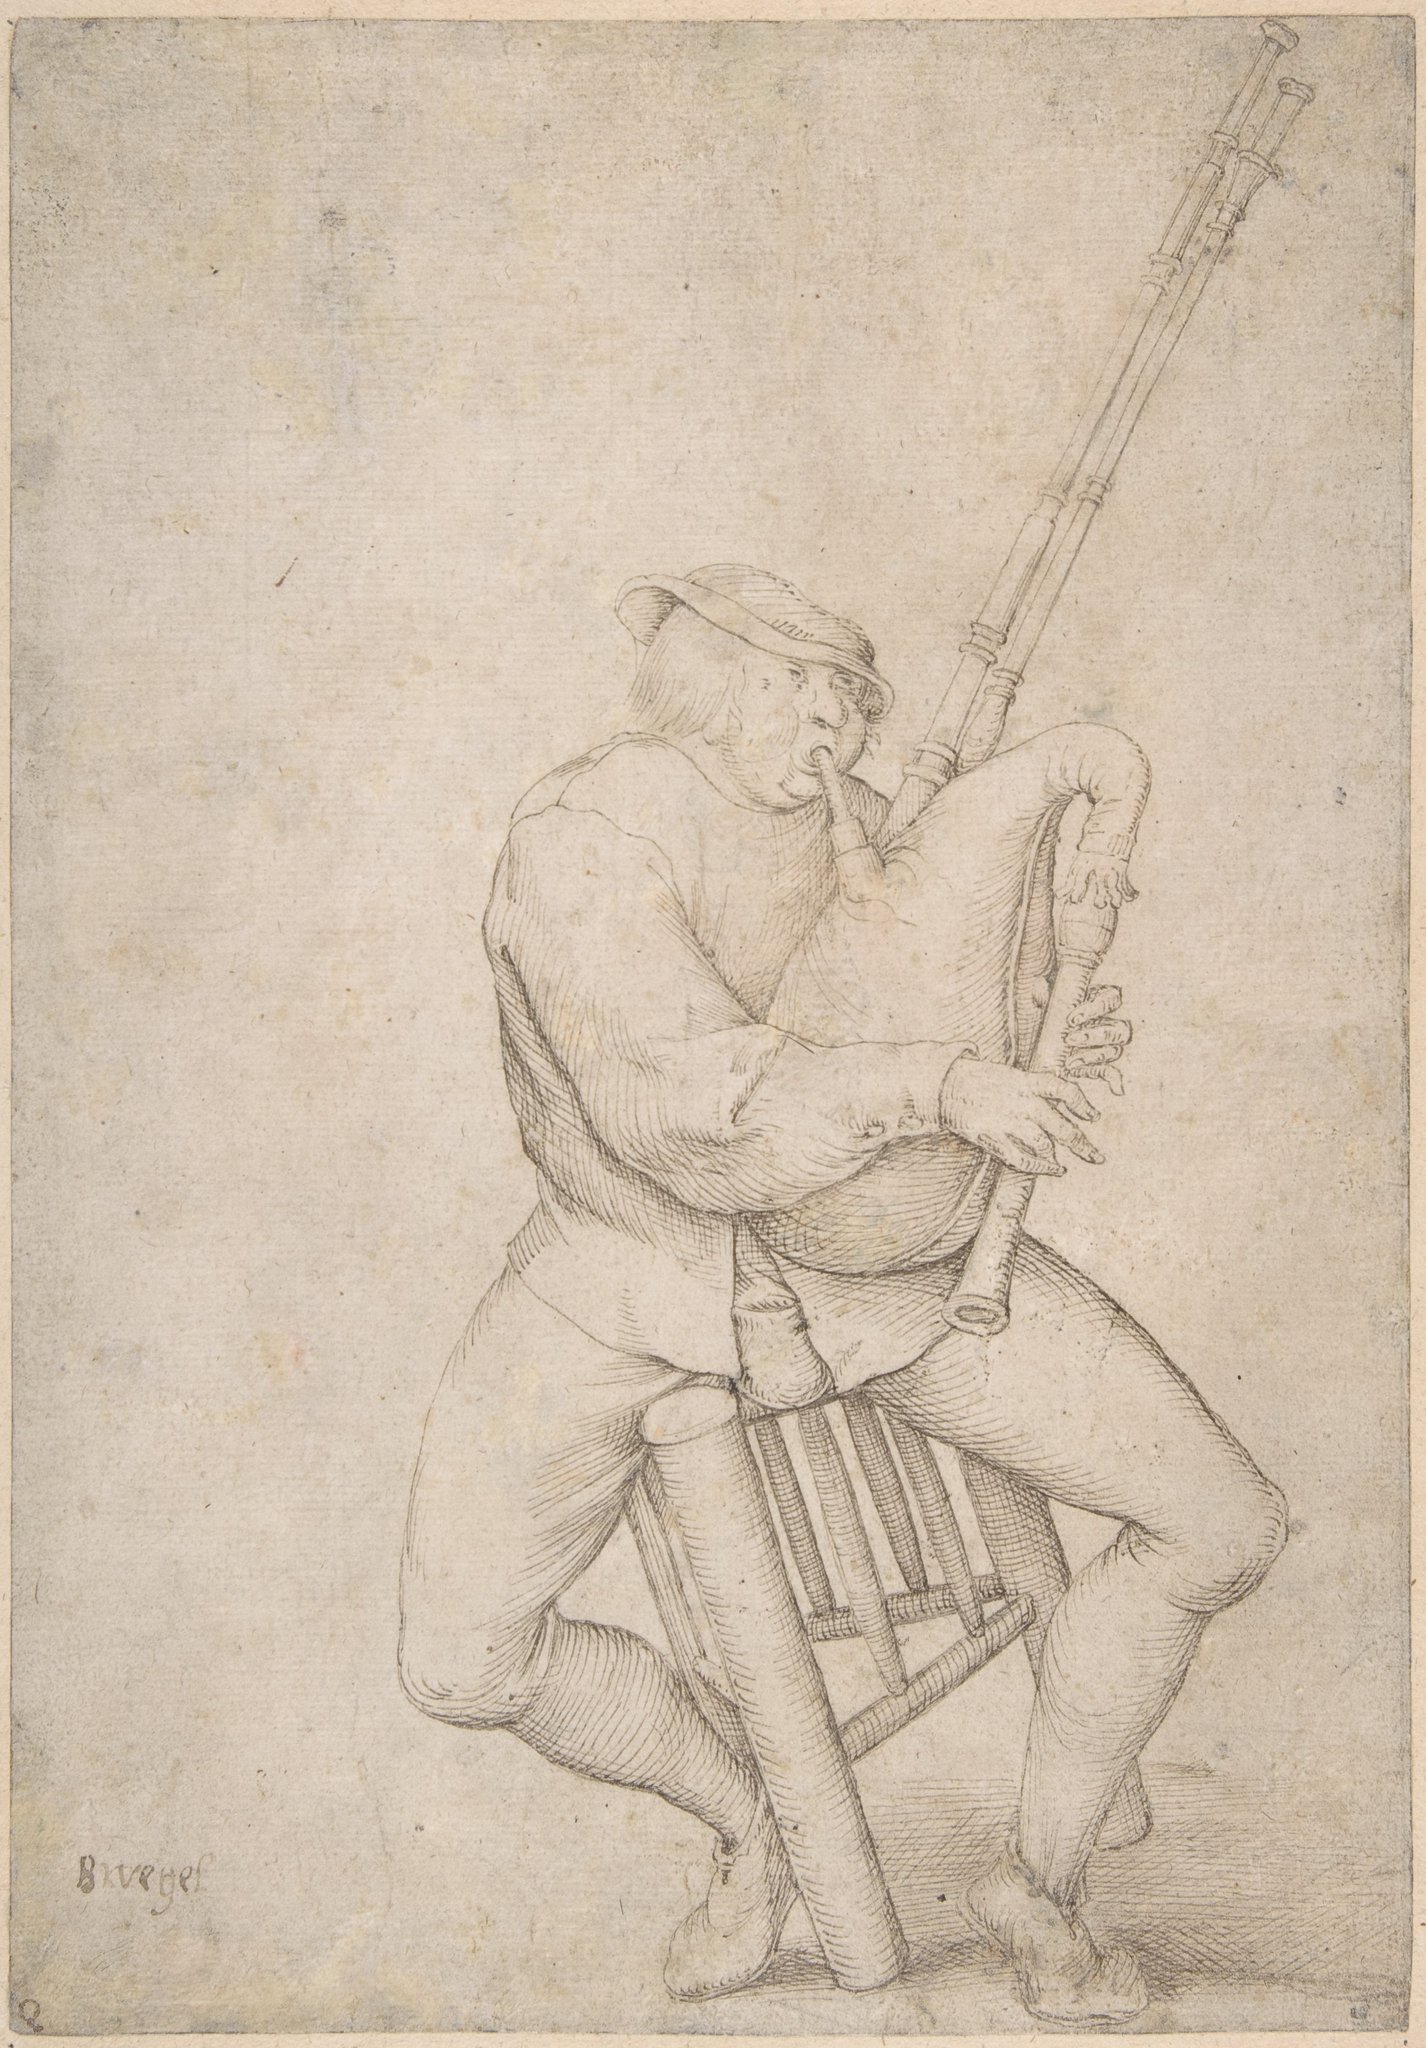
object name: binding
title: Seated Man, Precariously Balanced, Playing Bagpipes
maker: anonymous, netherlandish, 16th century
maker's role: artist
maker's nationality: netherlandish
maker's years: 1500-1600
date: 1501-1600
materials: ink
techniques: pen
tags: men,bagpipes